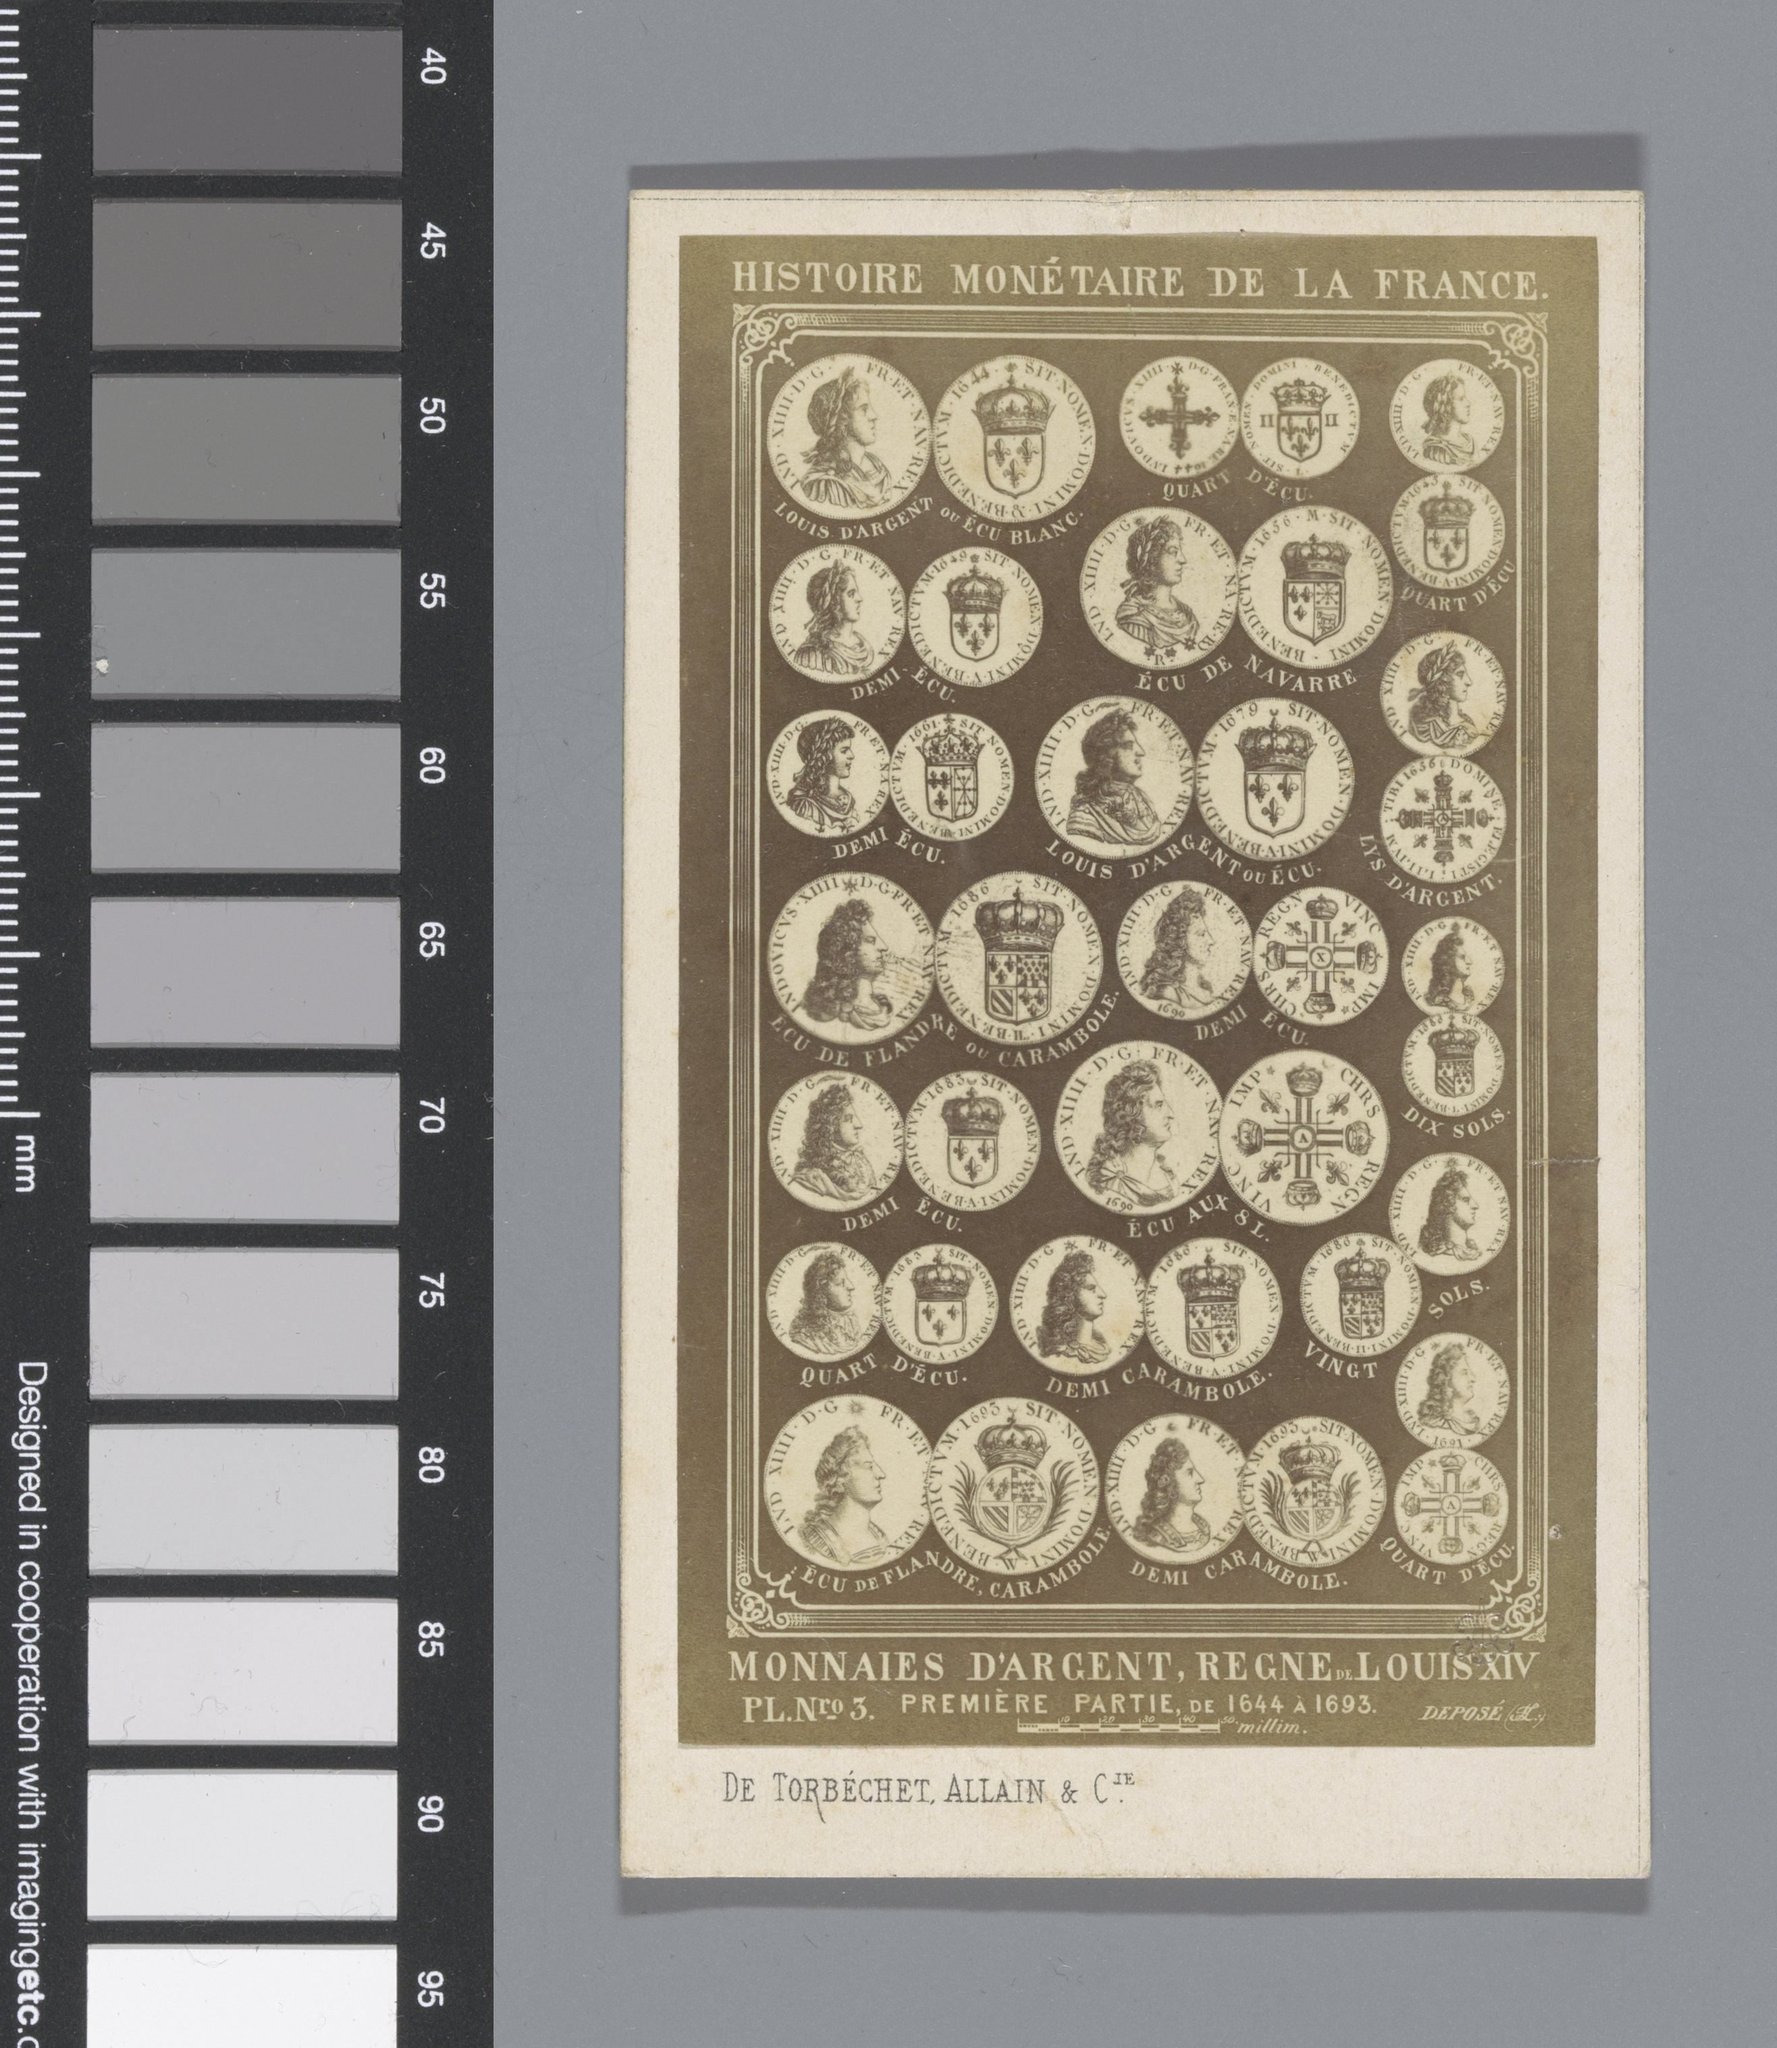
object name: carte de visite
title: Histoire monétaire de la France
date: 1865-1870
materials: cardboard, paper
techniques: albumen print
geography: paris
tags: money, france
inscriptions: inscription: ‘De Torbéchet, Allain & Cie.’, inscription: ‘Photographie/ Saint Thomas d'Aquin/ 44, Rue St Dominique/ St. Germain/ Au Rez-de-Chaussée/ Photographie Microscopique/ Brevetée s.g.d.g./ Imp. Gasté. Paris.’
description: 6 cartes-de-visite (mozaïeken) van de monetaire geschiedenis van Frankrijk.